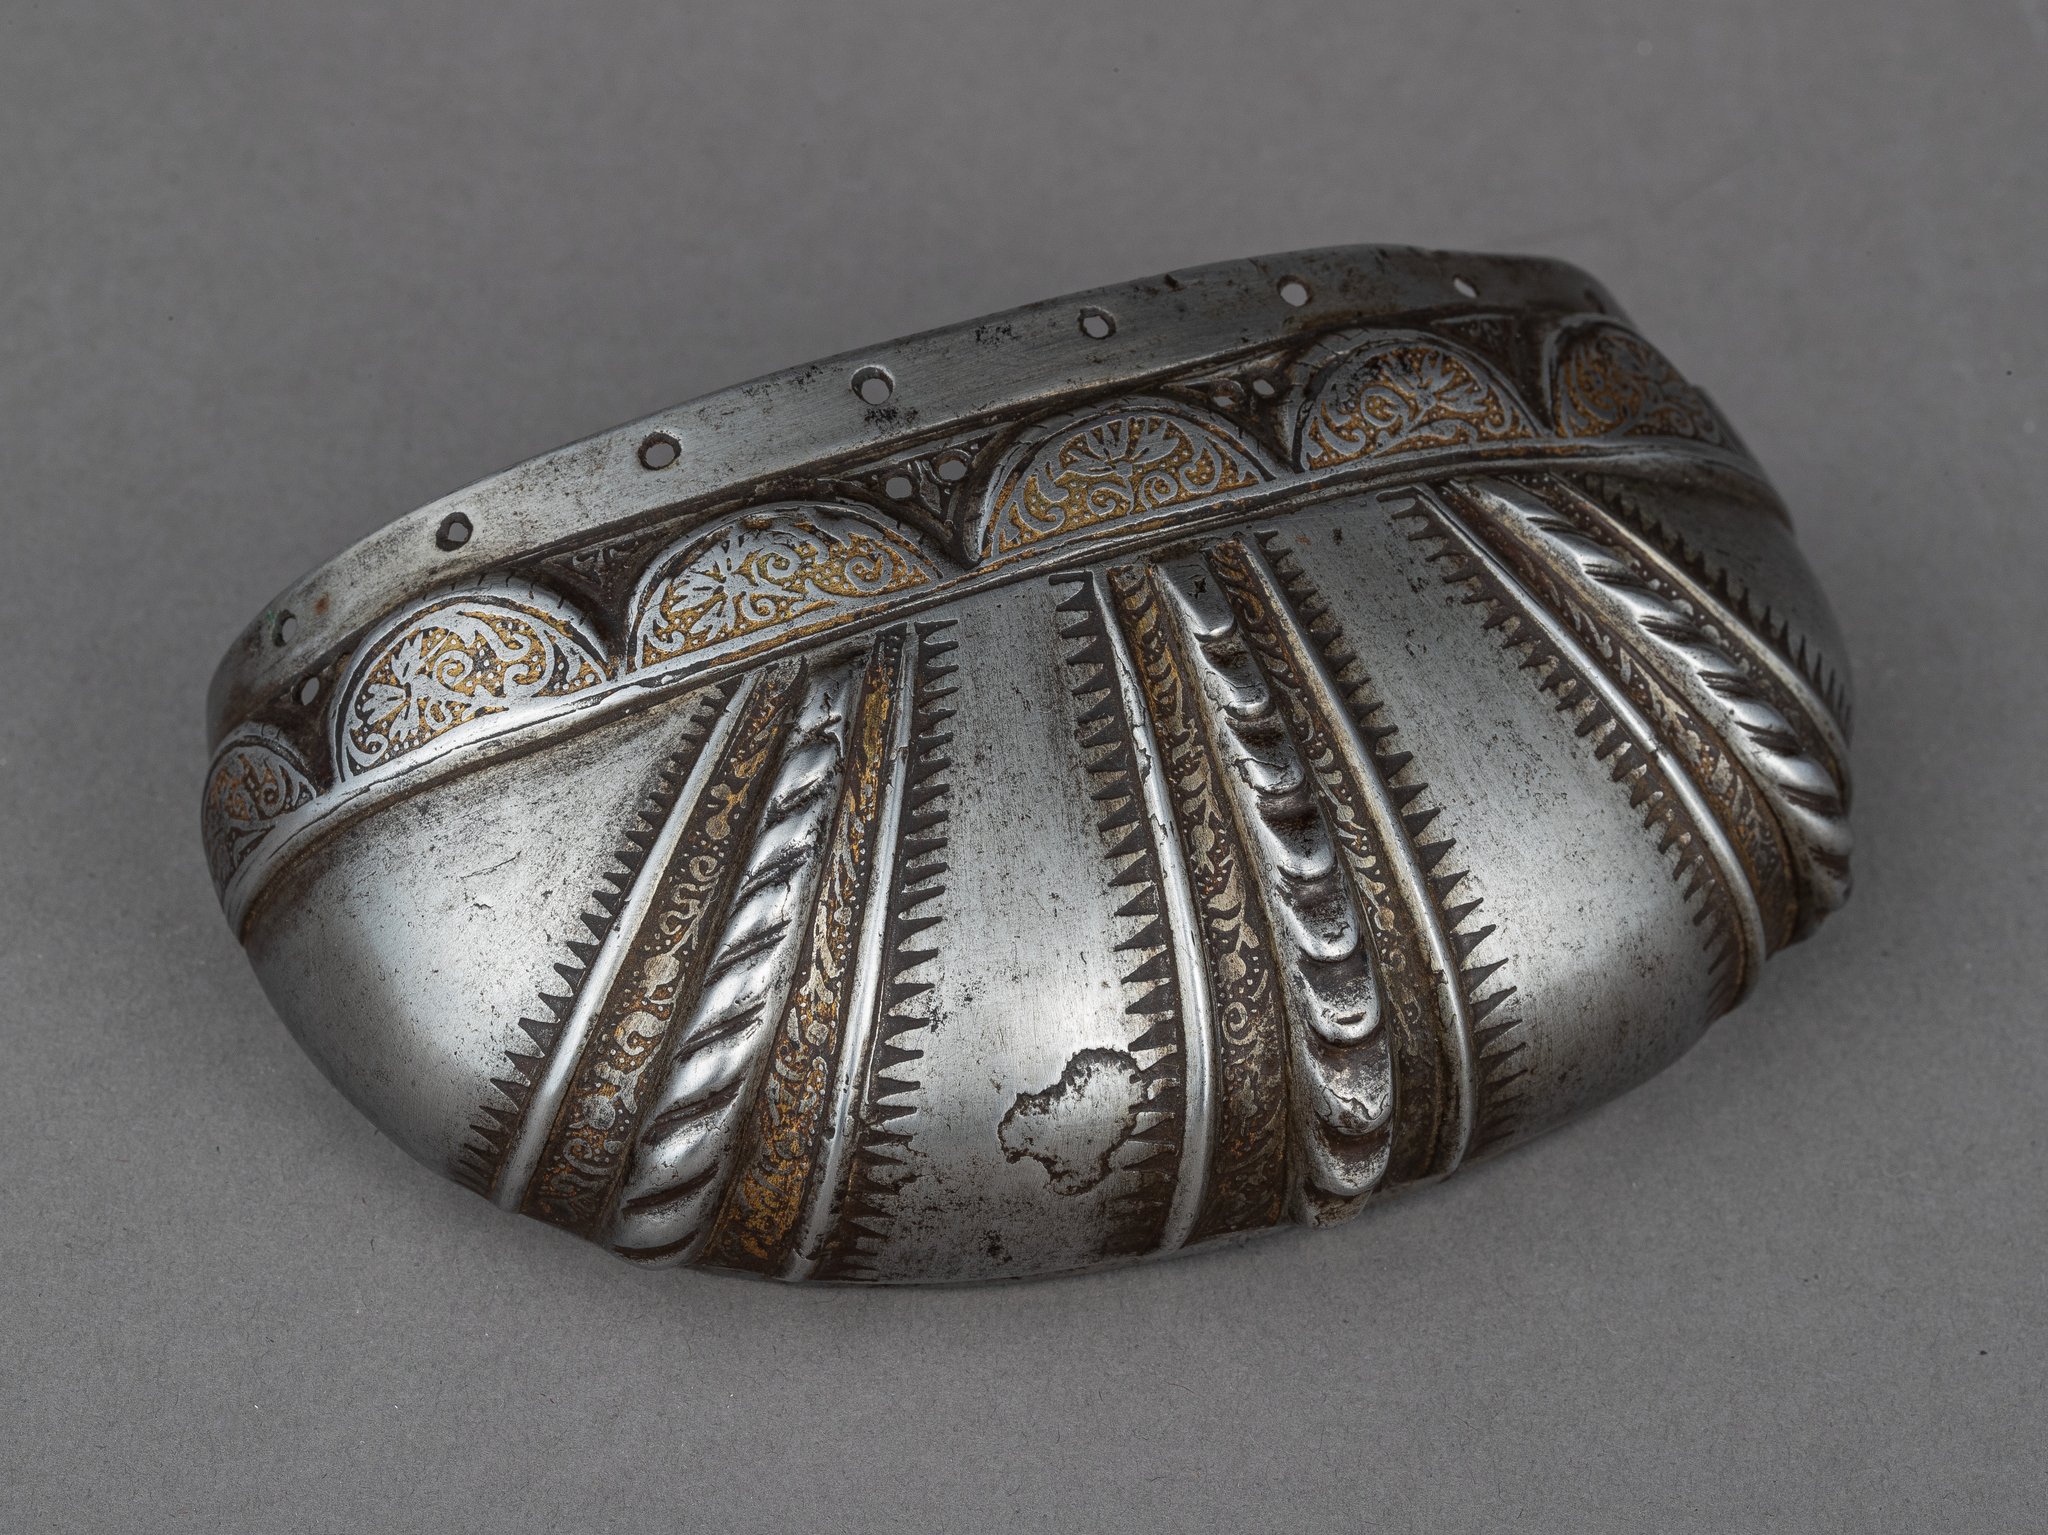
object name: toe cap for a foot defense sabaton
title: Toe Cap for a Foot Defense (Sabaton)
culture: german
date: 1525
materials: gold, steel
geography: germany